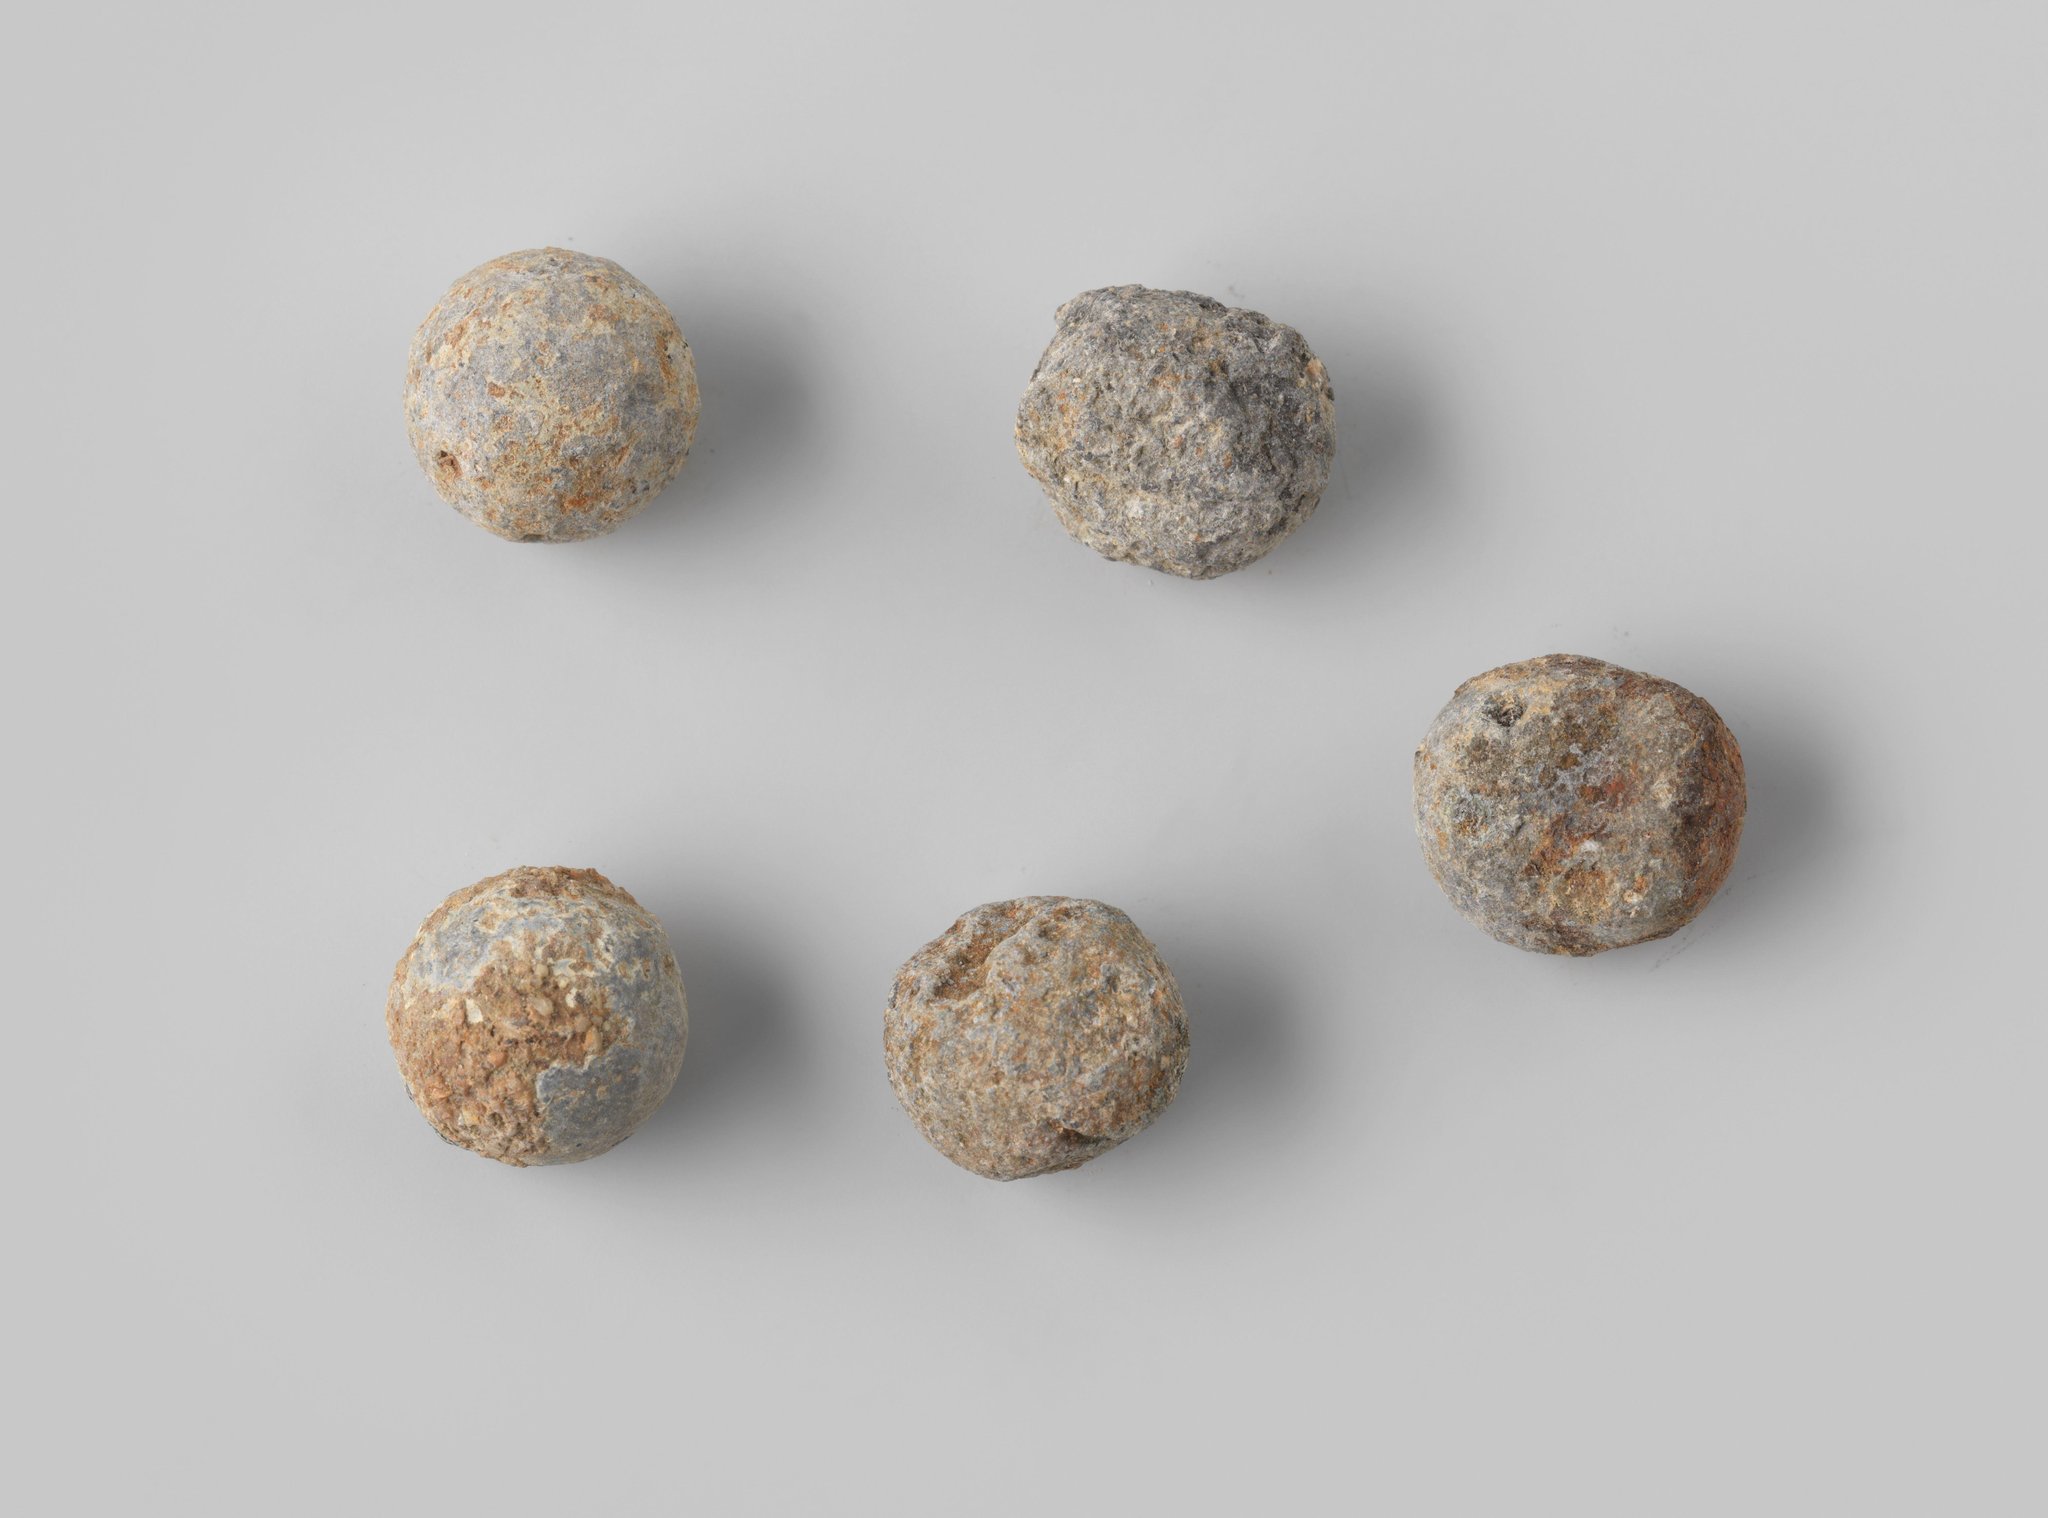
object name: musketkogel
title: Musketkogels uit het wrak van de Oost-Indiëvaarder Hollandia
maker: Anonymous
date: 1700-1743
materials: lead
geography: netherlands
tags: verenigde oostindische compagnie, hollandia (schip), annet